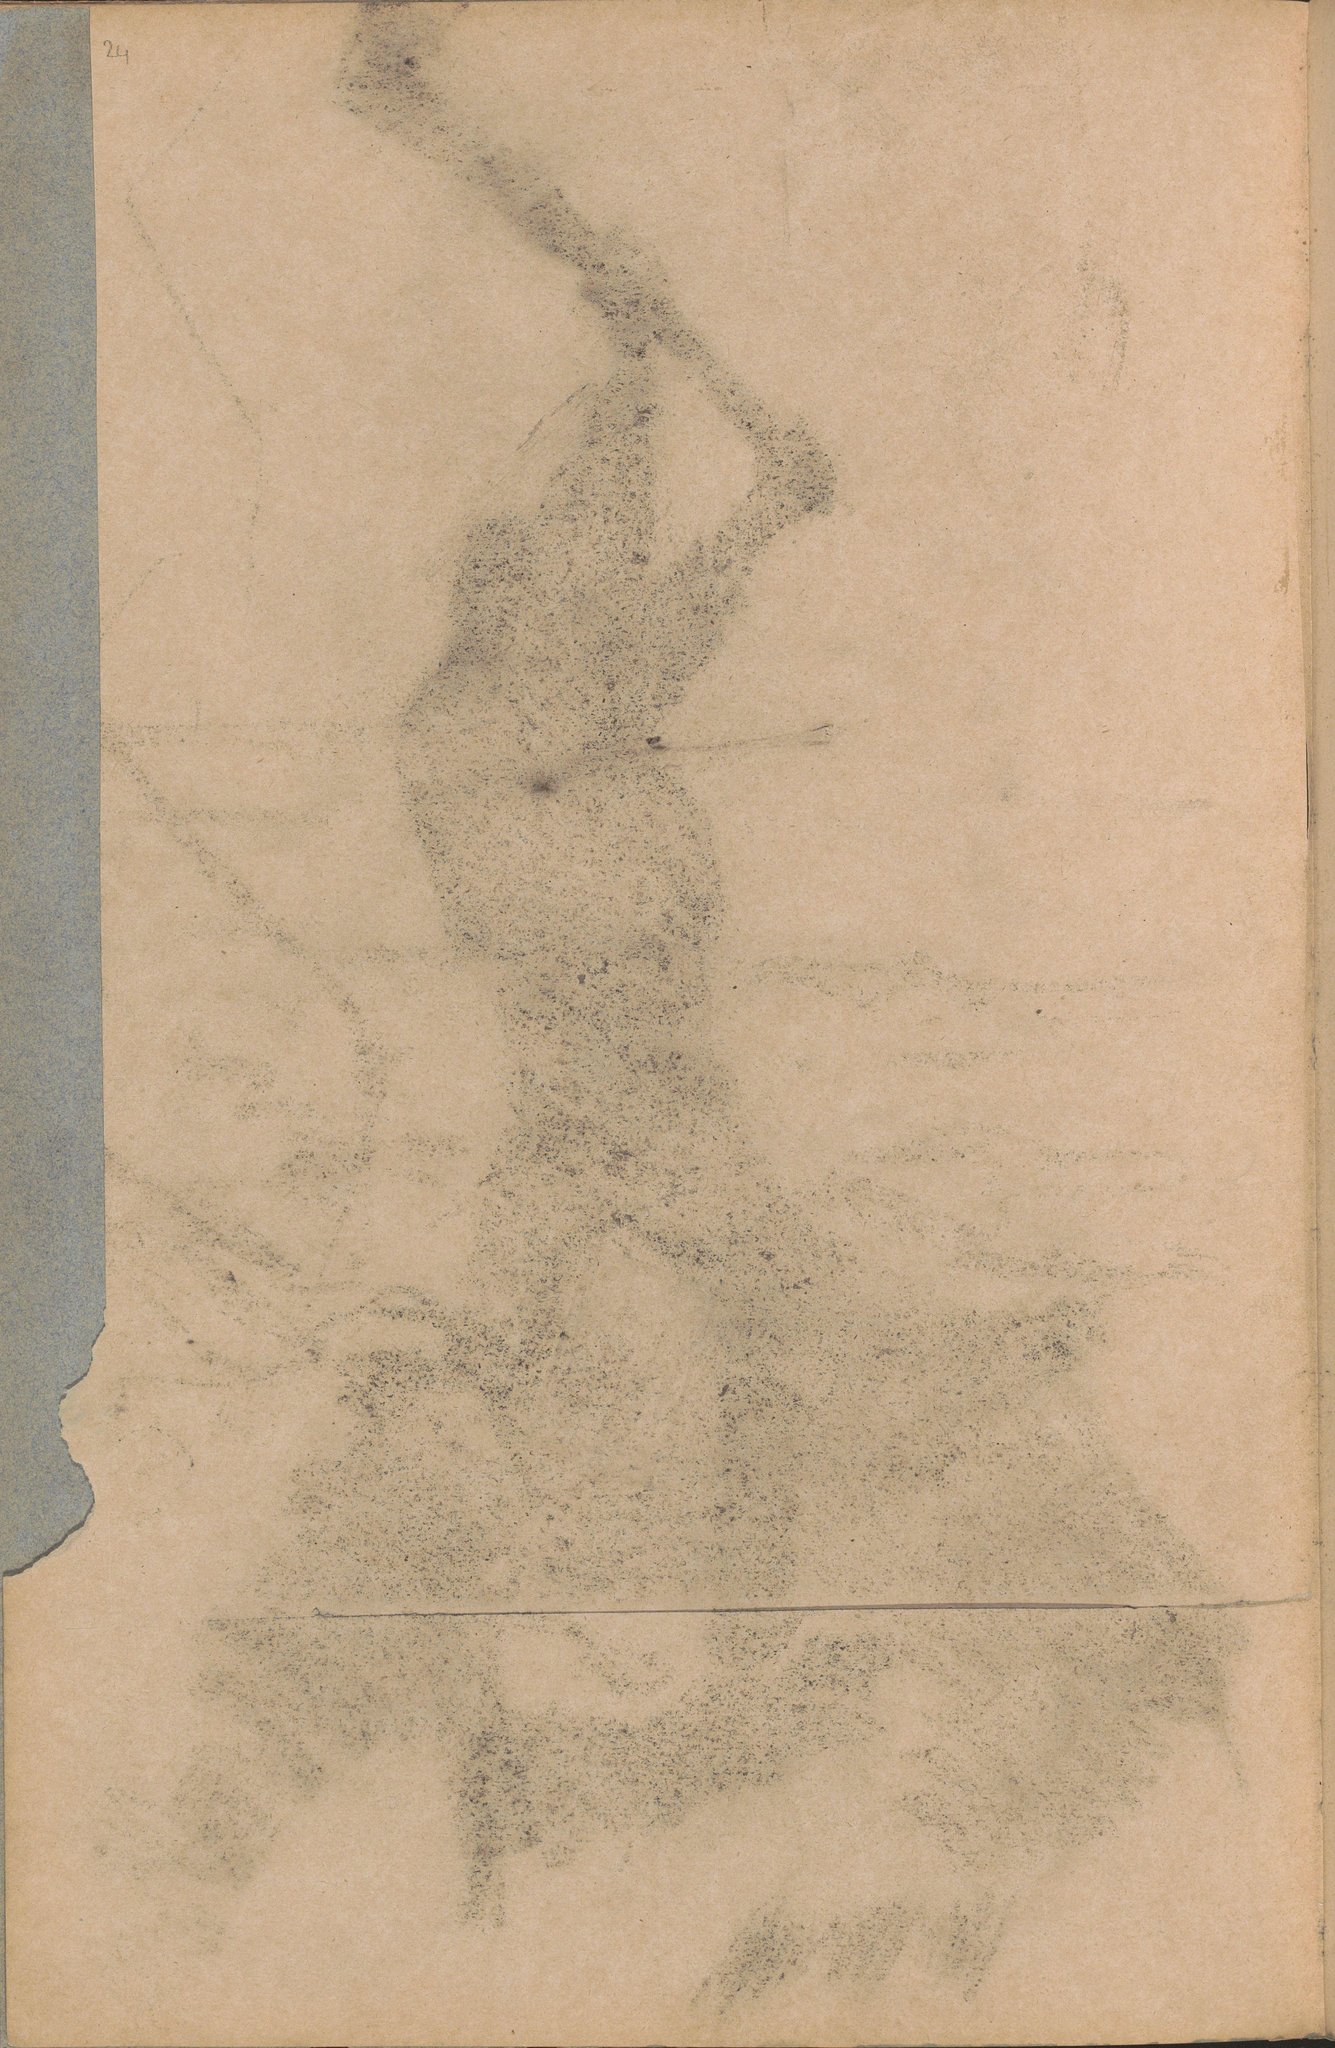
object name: sketchbook leaf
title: Abklatsch van de krijttekening op pagina 25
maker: willem witsen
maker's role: draughtsman, painter, print maker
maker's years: 1860-1923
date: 1884-1887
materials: paper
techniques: printmaking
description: Pagina 24 uit een schetsboek met 38 bladen.